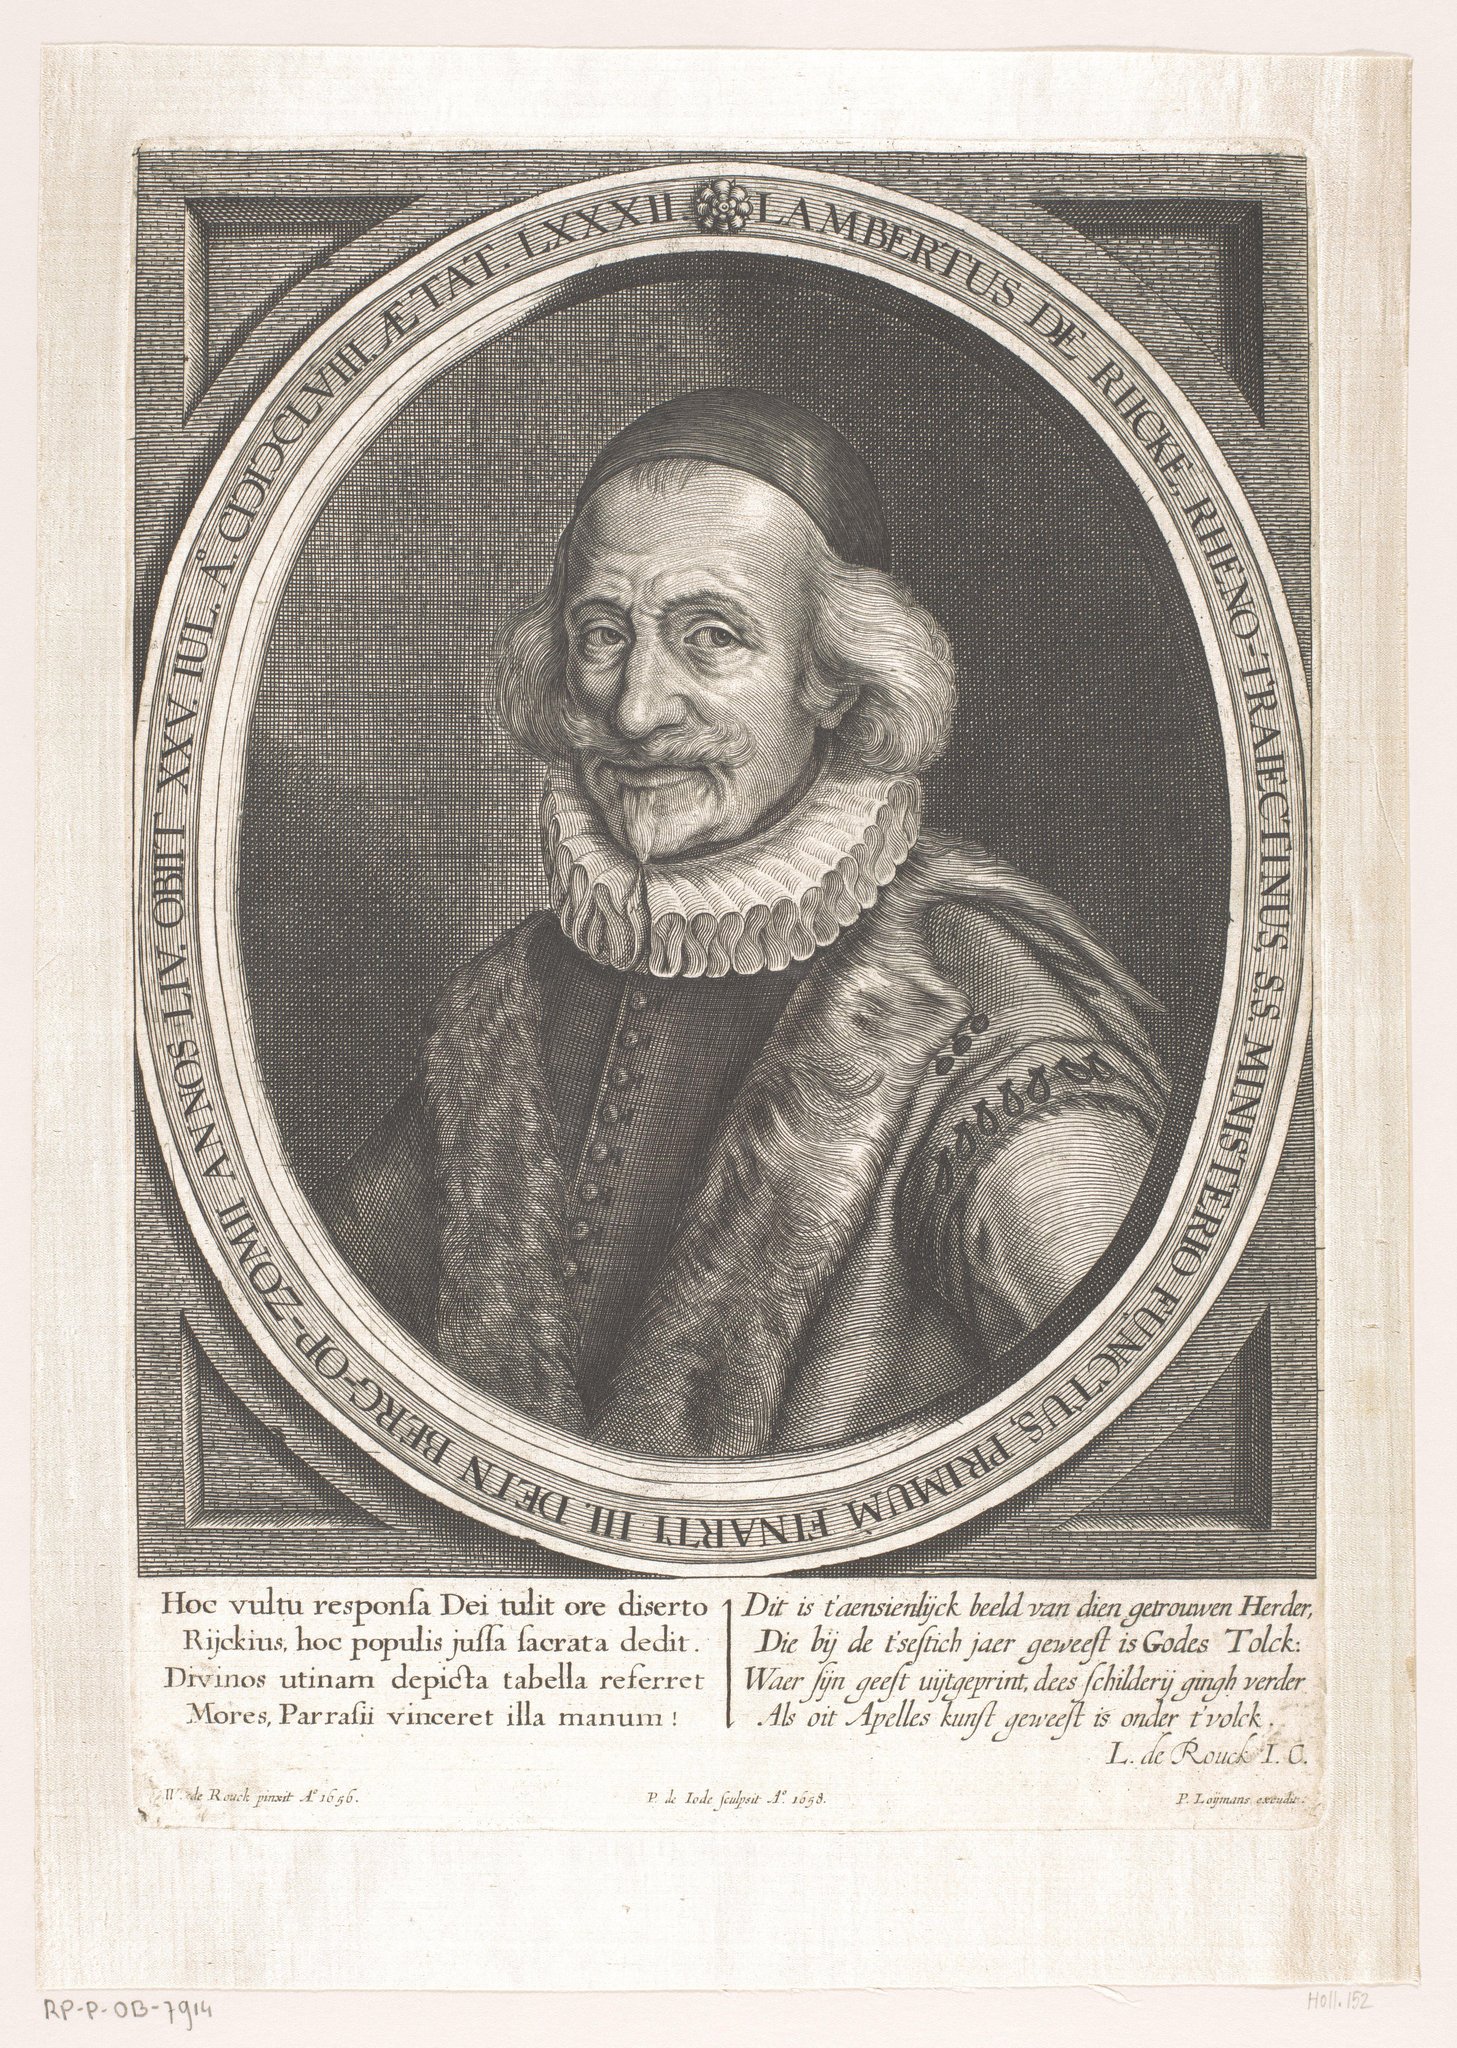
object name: print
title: Portret van Lambert de Rycke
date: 1658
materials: silk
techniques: engraving, etching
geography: antwerp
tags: theoloog, lambertus de rycke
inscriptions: date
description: Busteportret van Lambert de Rycke op 82-jarige leeftijd, met kalot. Het portret is gevat in een ovale omlijsting met een randschrift in het Latijn en met vierkant randwerk. In de marge een vierregelig gedicht, in twee kolommen, in het Latijn en in het Nederlands.